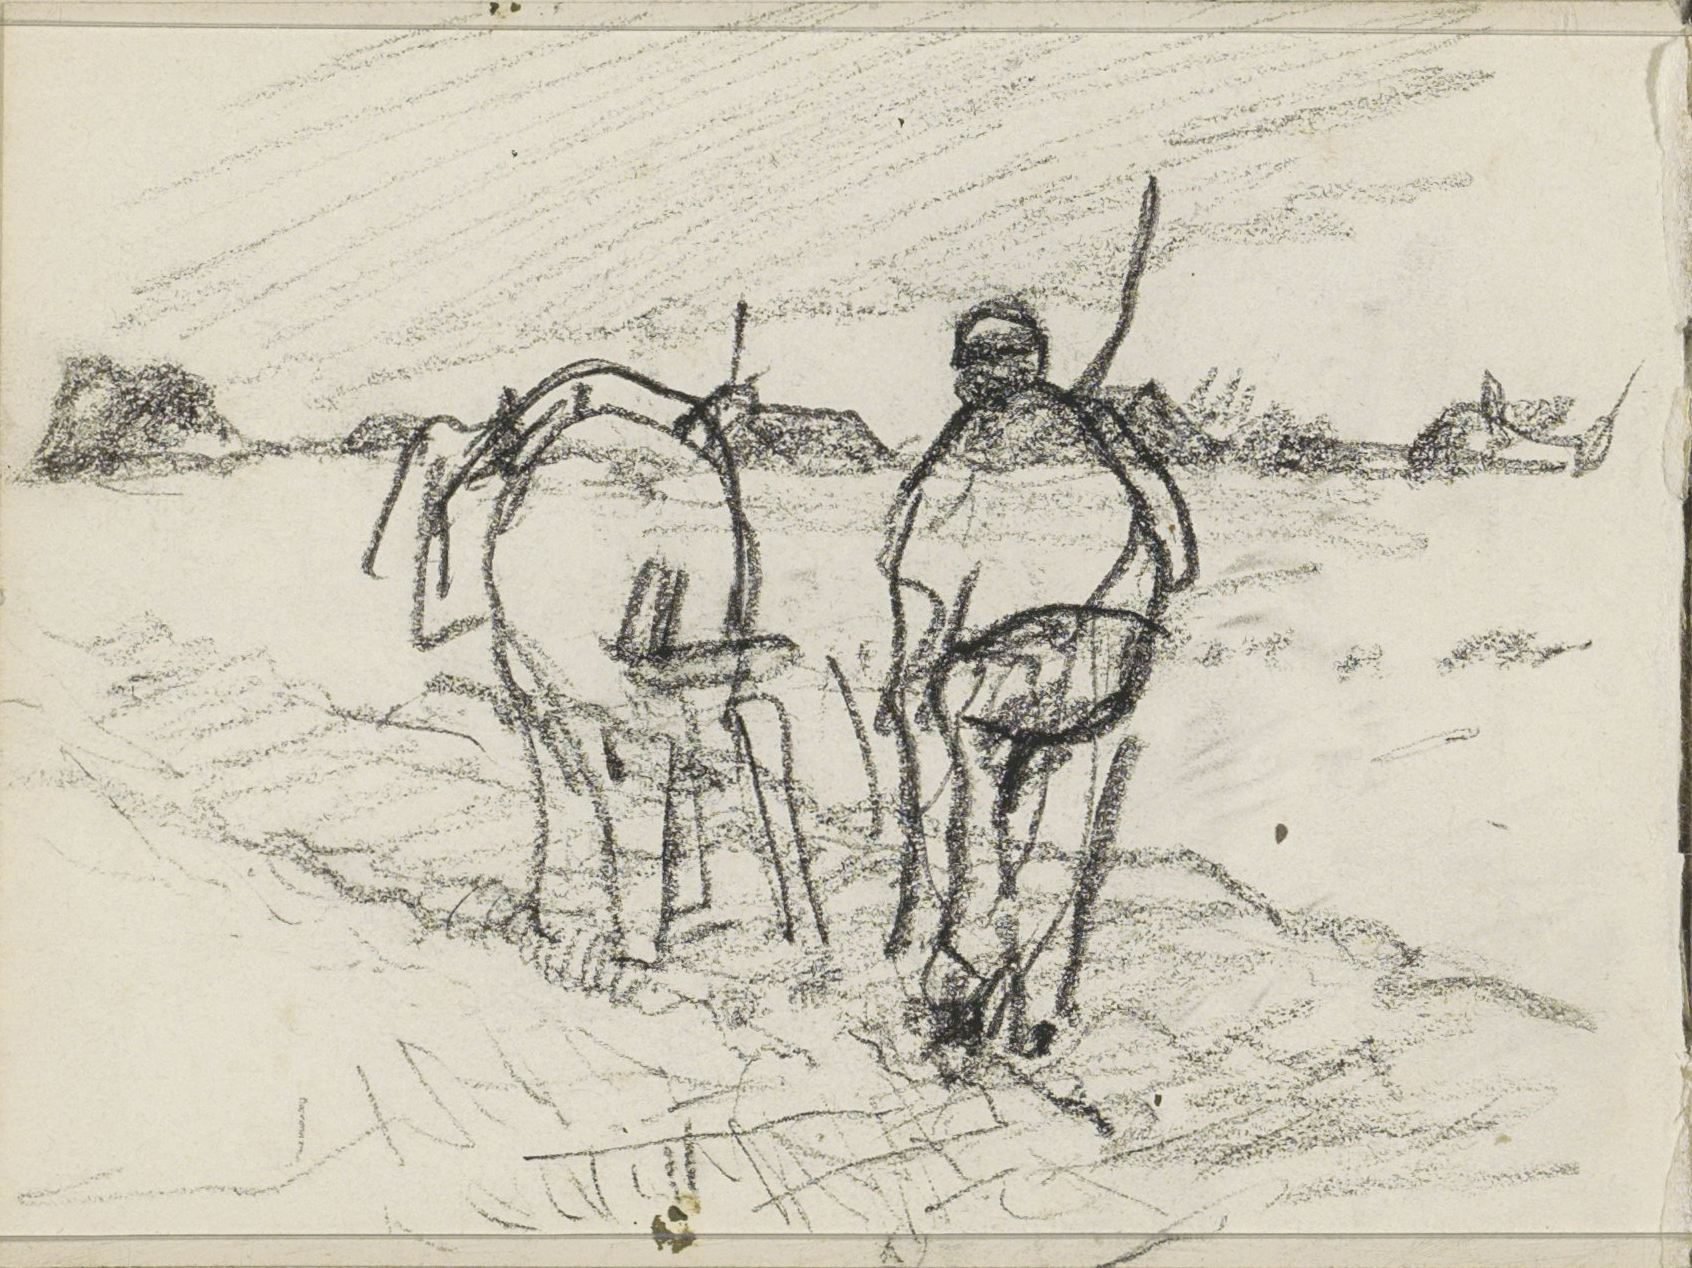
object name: sketchbook leaf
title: Ploegen op het land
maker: anton mauve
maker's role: draughtsman, painter, print maker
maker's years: 1838-1888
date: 1881-1888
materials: chalk, paper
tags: ploughing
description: Blad 4 verso uit een schetsboek met 29 bladen.